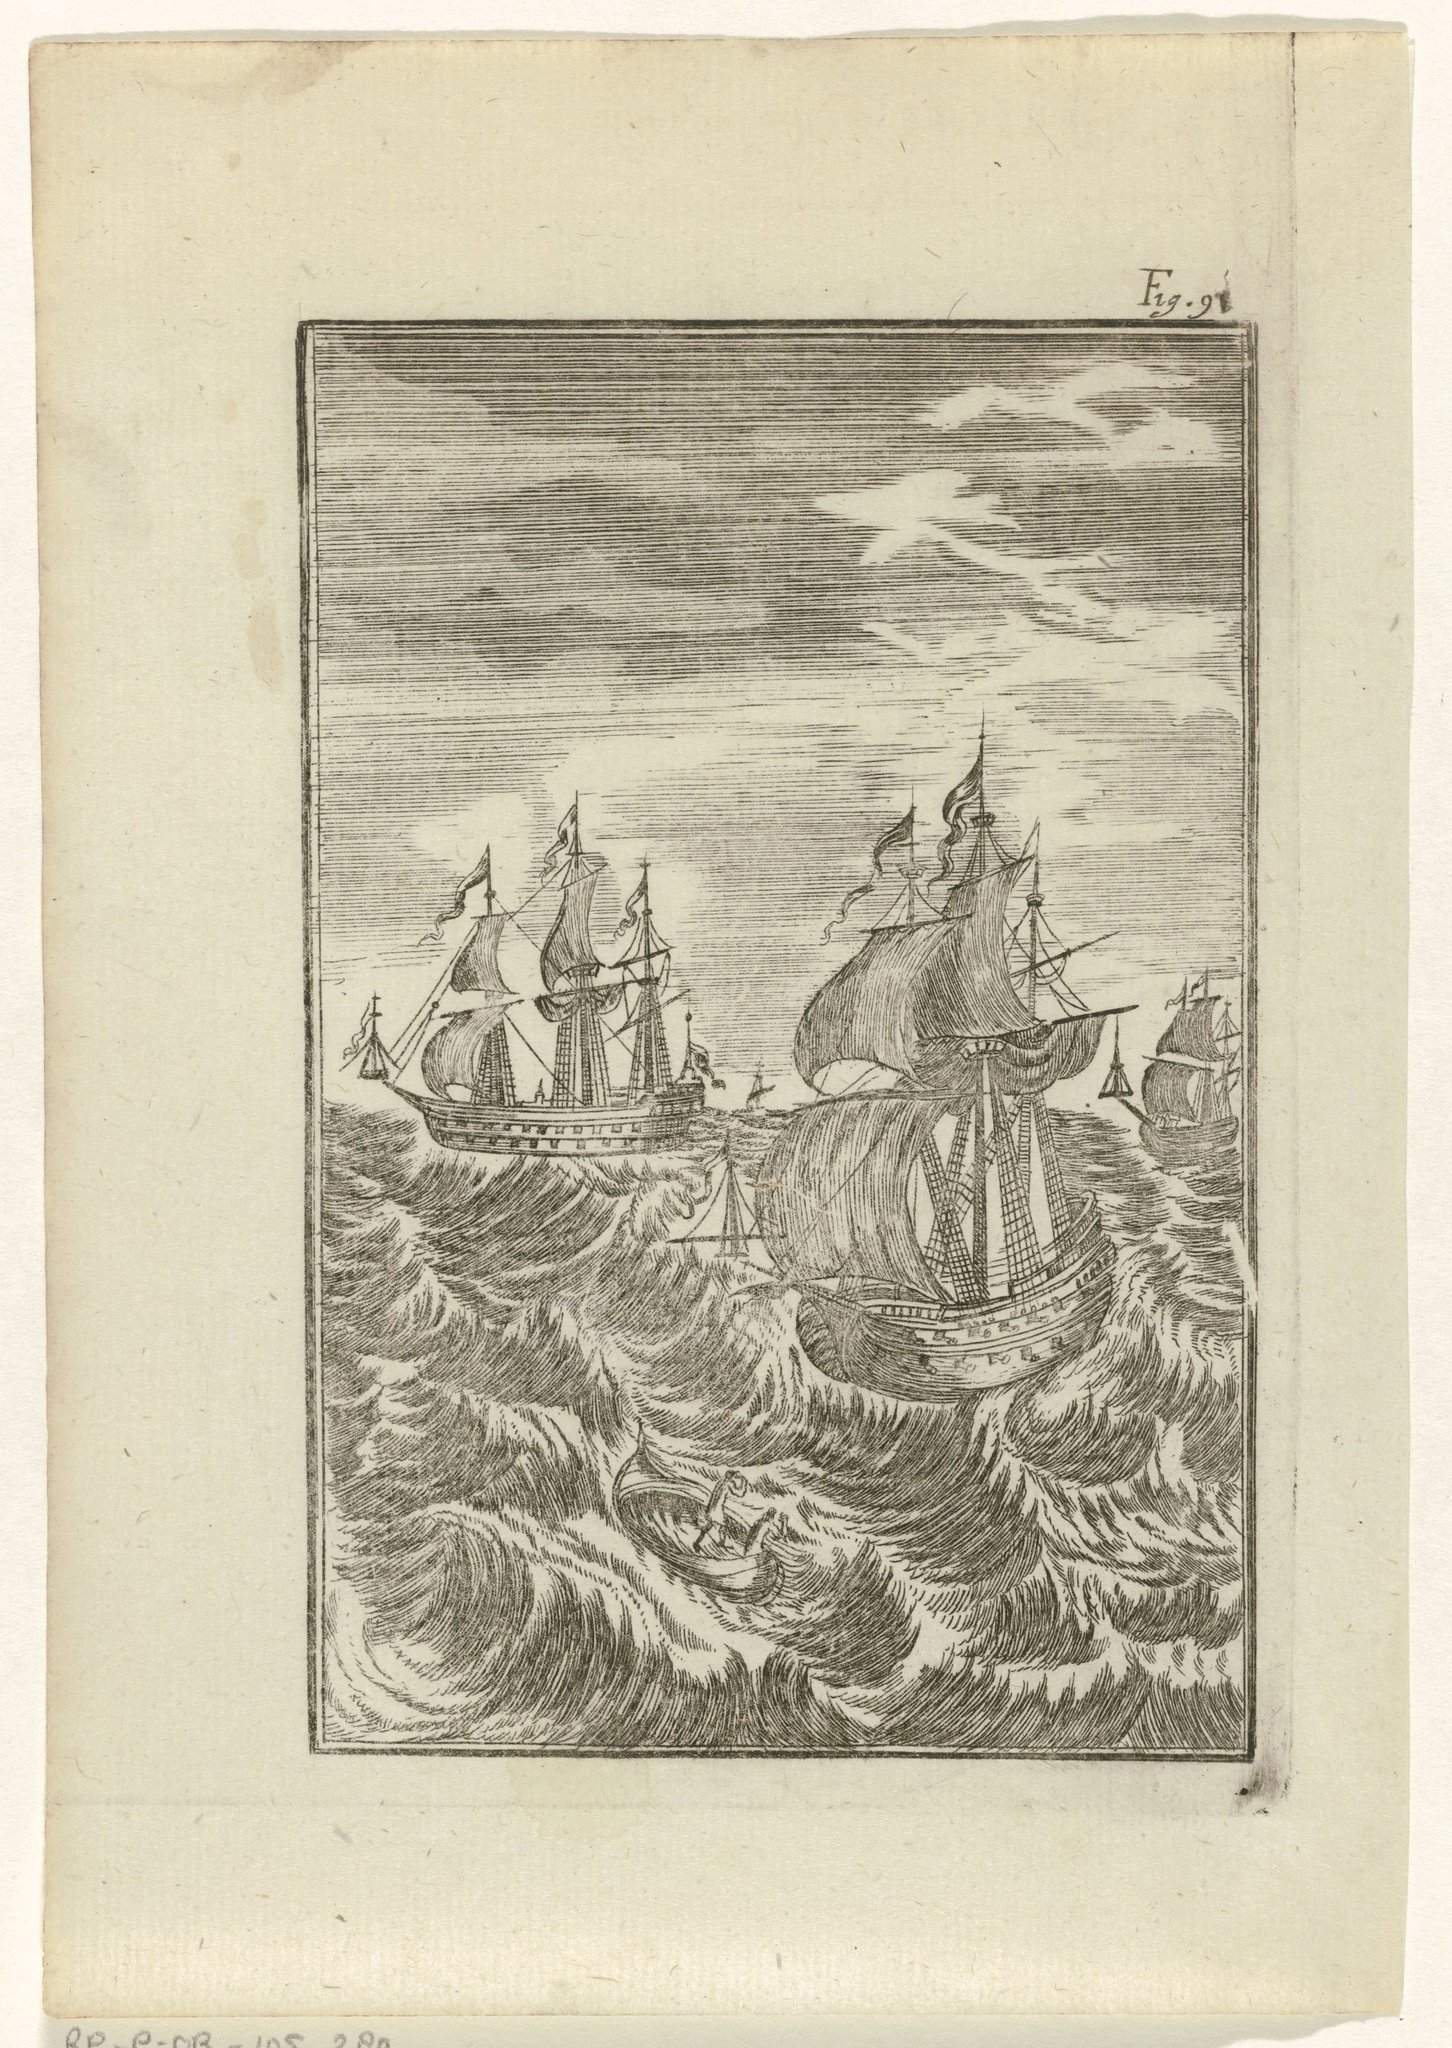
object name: print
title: Drie zeilschepen en een sloep op woeste zee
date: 1719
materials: paper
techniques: etching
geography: frankfurt am main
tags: wave, sailing-ship, sailing-boat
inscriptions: collector's mark: Lugt 2228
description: Boekillustratie uit: Mallet, Allain Manesson. Allain Manesson Mallets Beschreibung des gantzen Welt-Kreises. [Vertaald uit het Frans.] Frankkfurt am Main: Johann Adam Jung, 1719. De boekillustraties in deze uitgave zijn gekopieerd naar de boekillustraties in de originele Franse uitgave: Mallet, Allain Manesson. Description de l'univers. Parijs: Denis Thierry, 1683.